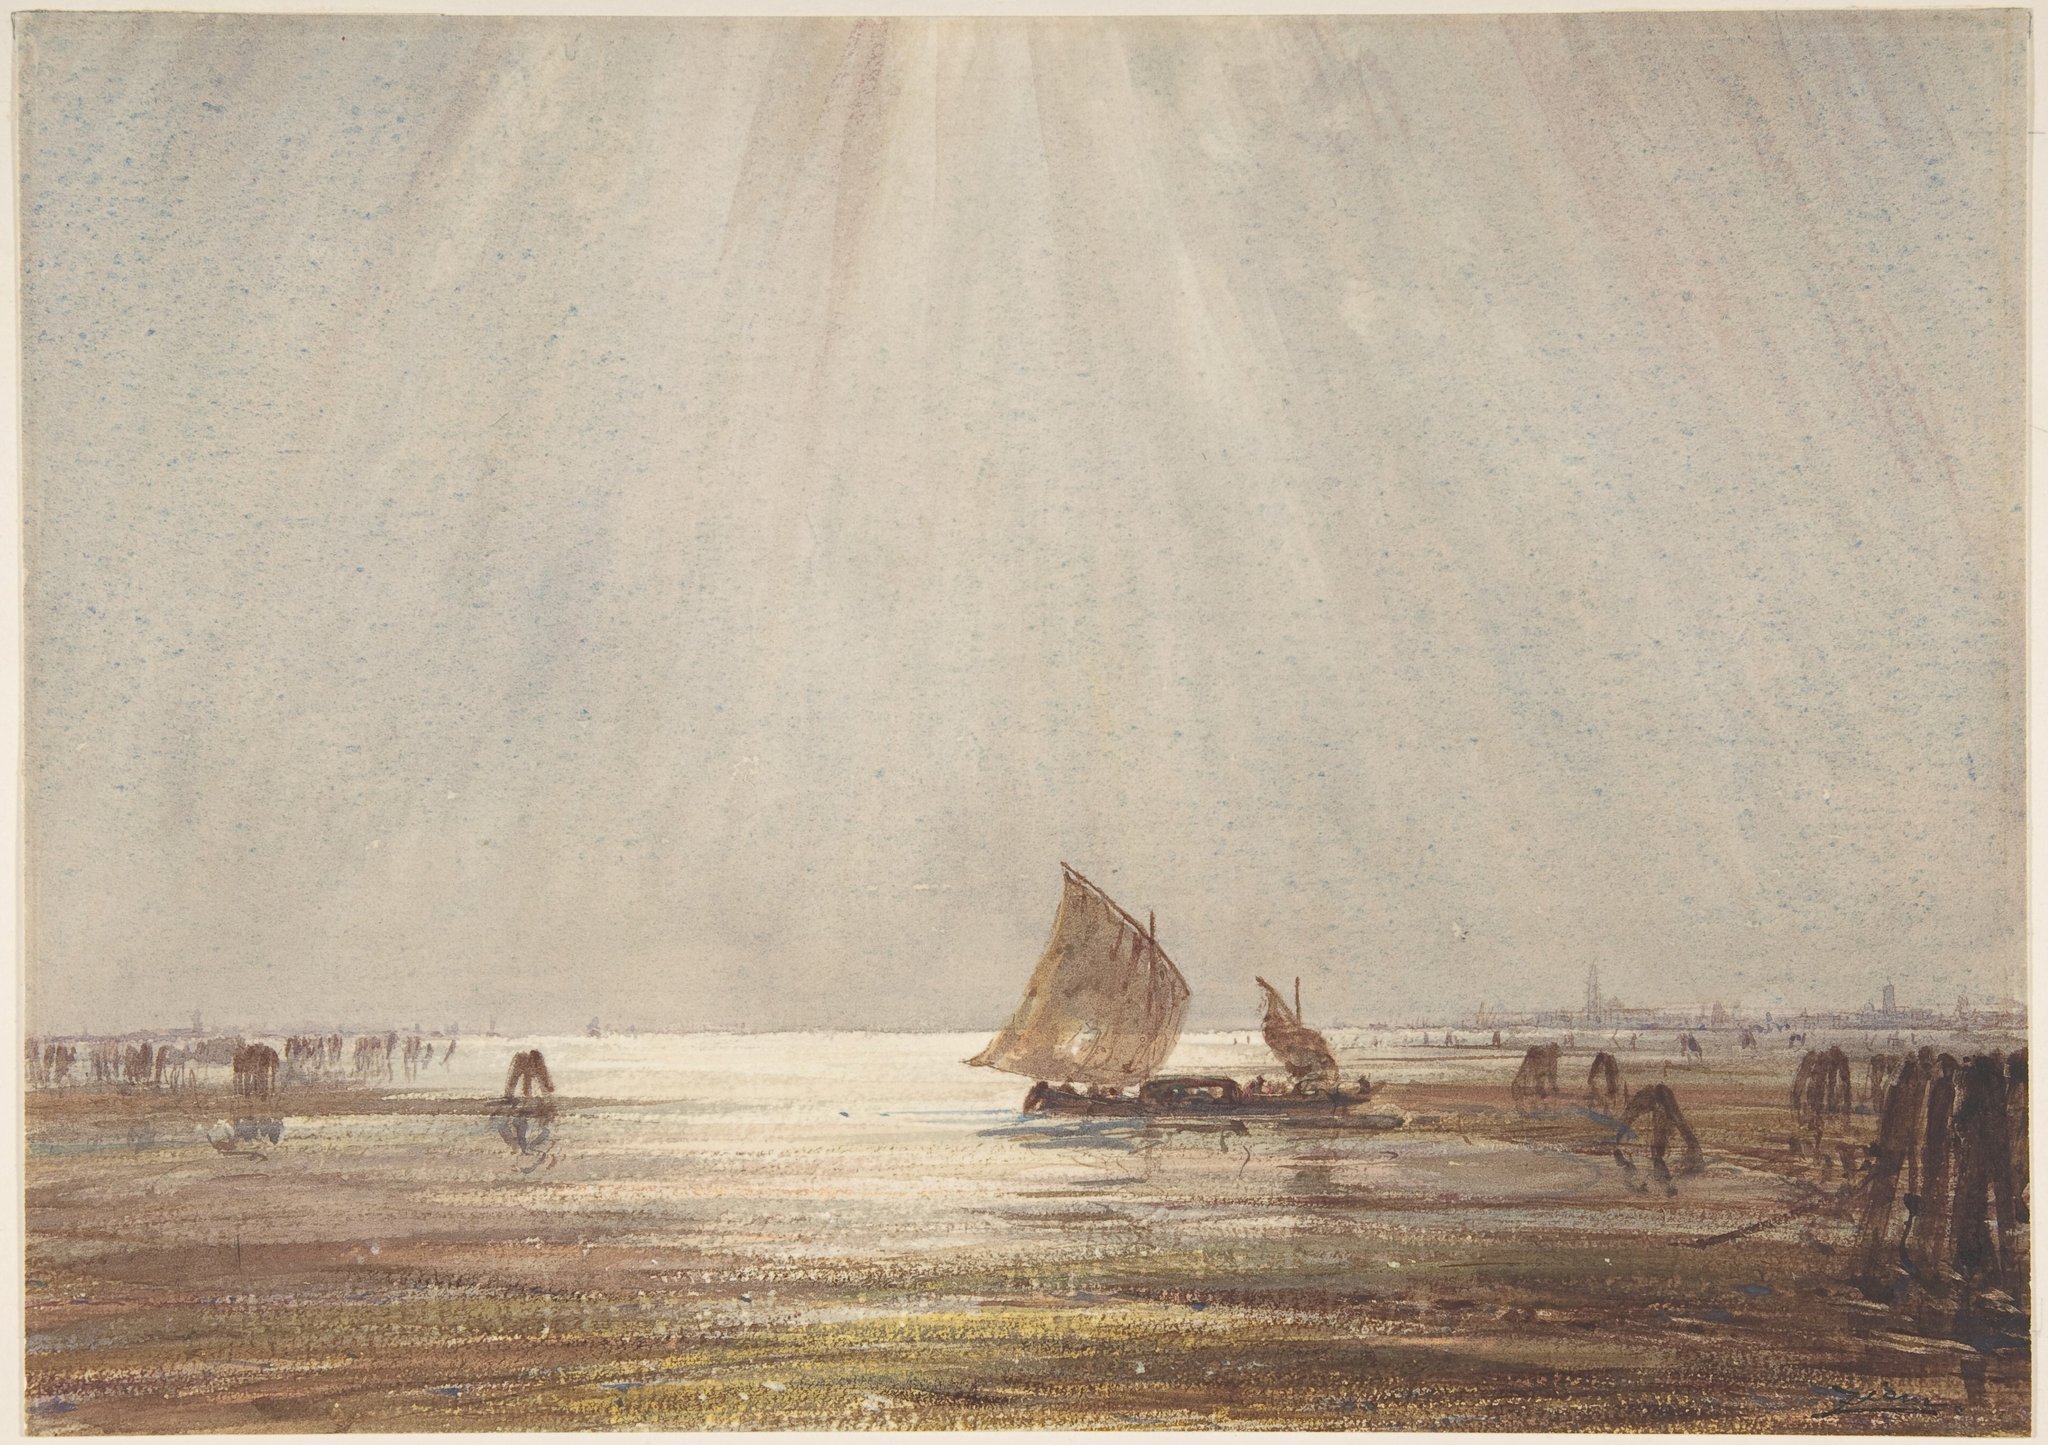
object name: drawing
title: Venetian fishing boat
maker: félix-françois-georges-philibert ziem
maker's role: artist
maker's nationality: french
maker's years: 1821-1911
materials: watercolor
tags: boats